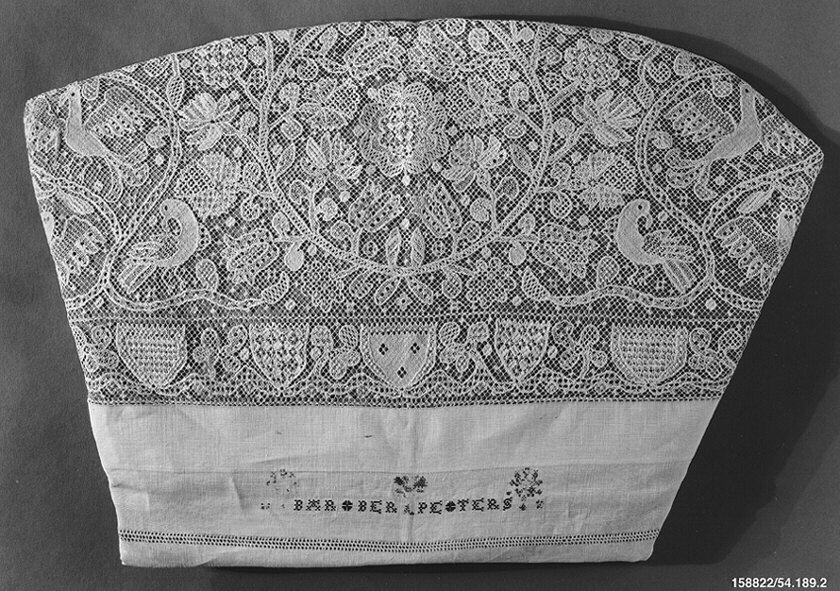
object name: pillowcase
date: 1701-1800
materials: linen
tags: birds,flowers